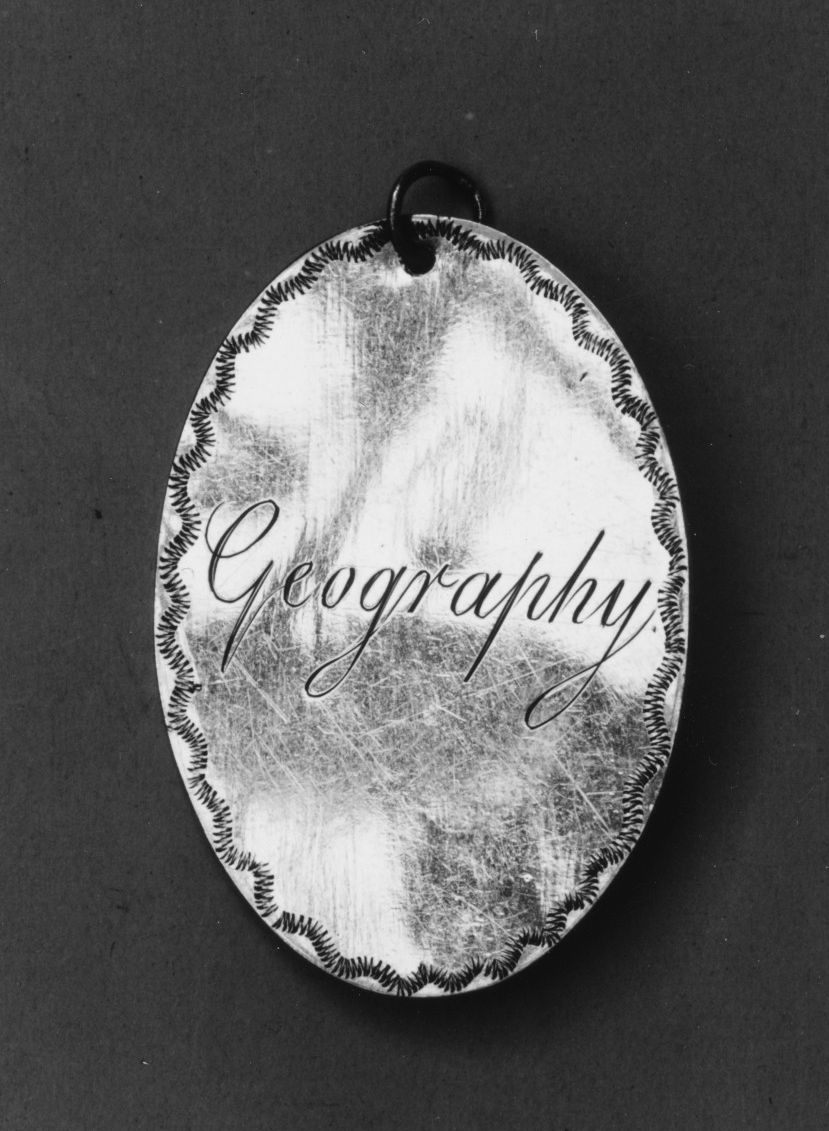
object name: medal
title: Scholarship Medal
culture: american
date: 1770-1830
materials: silver